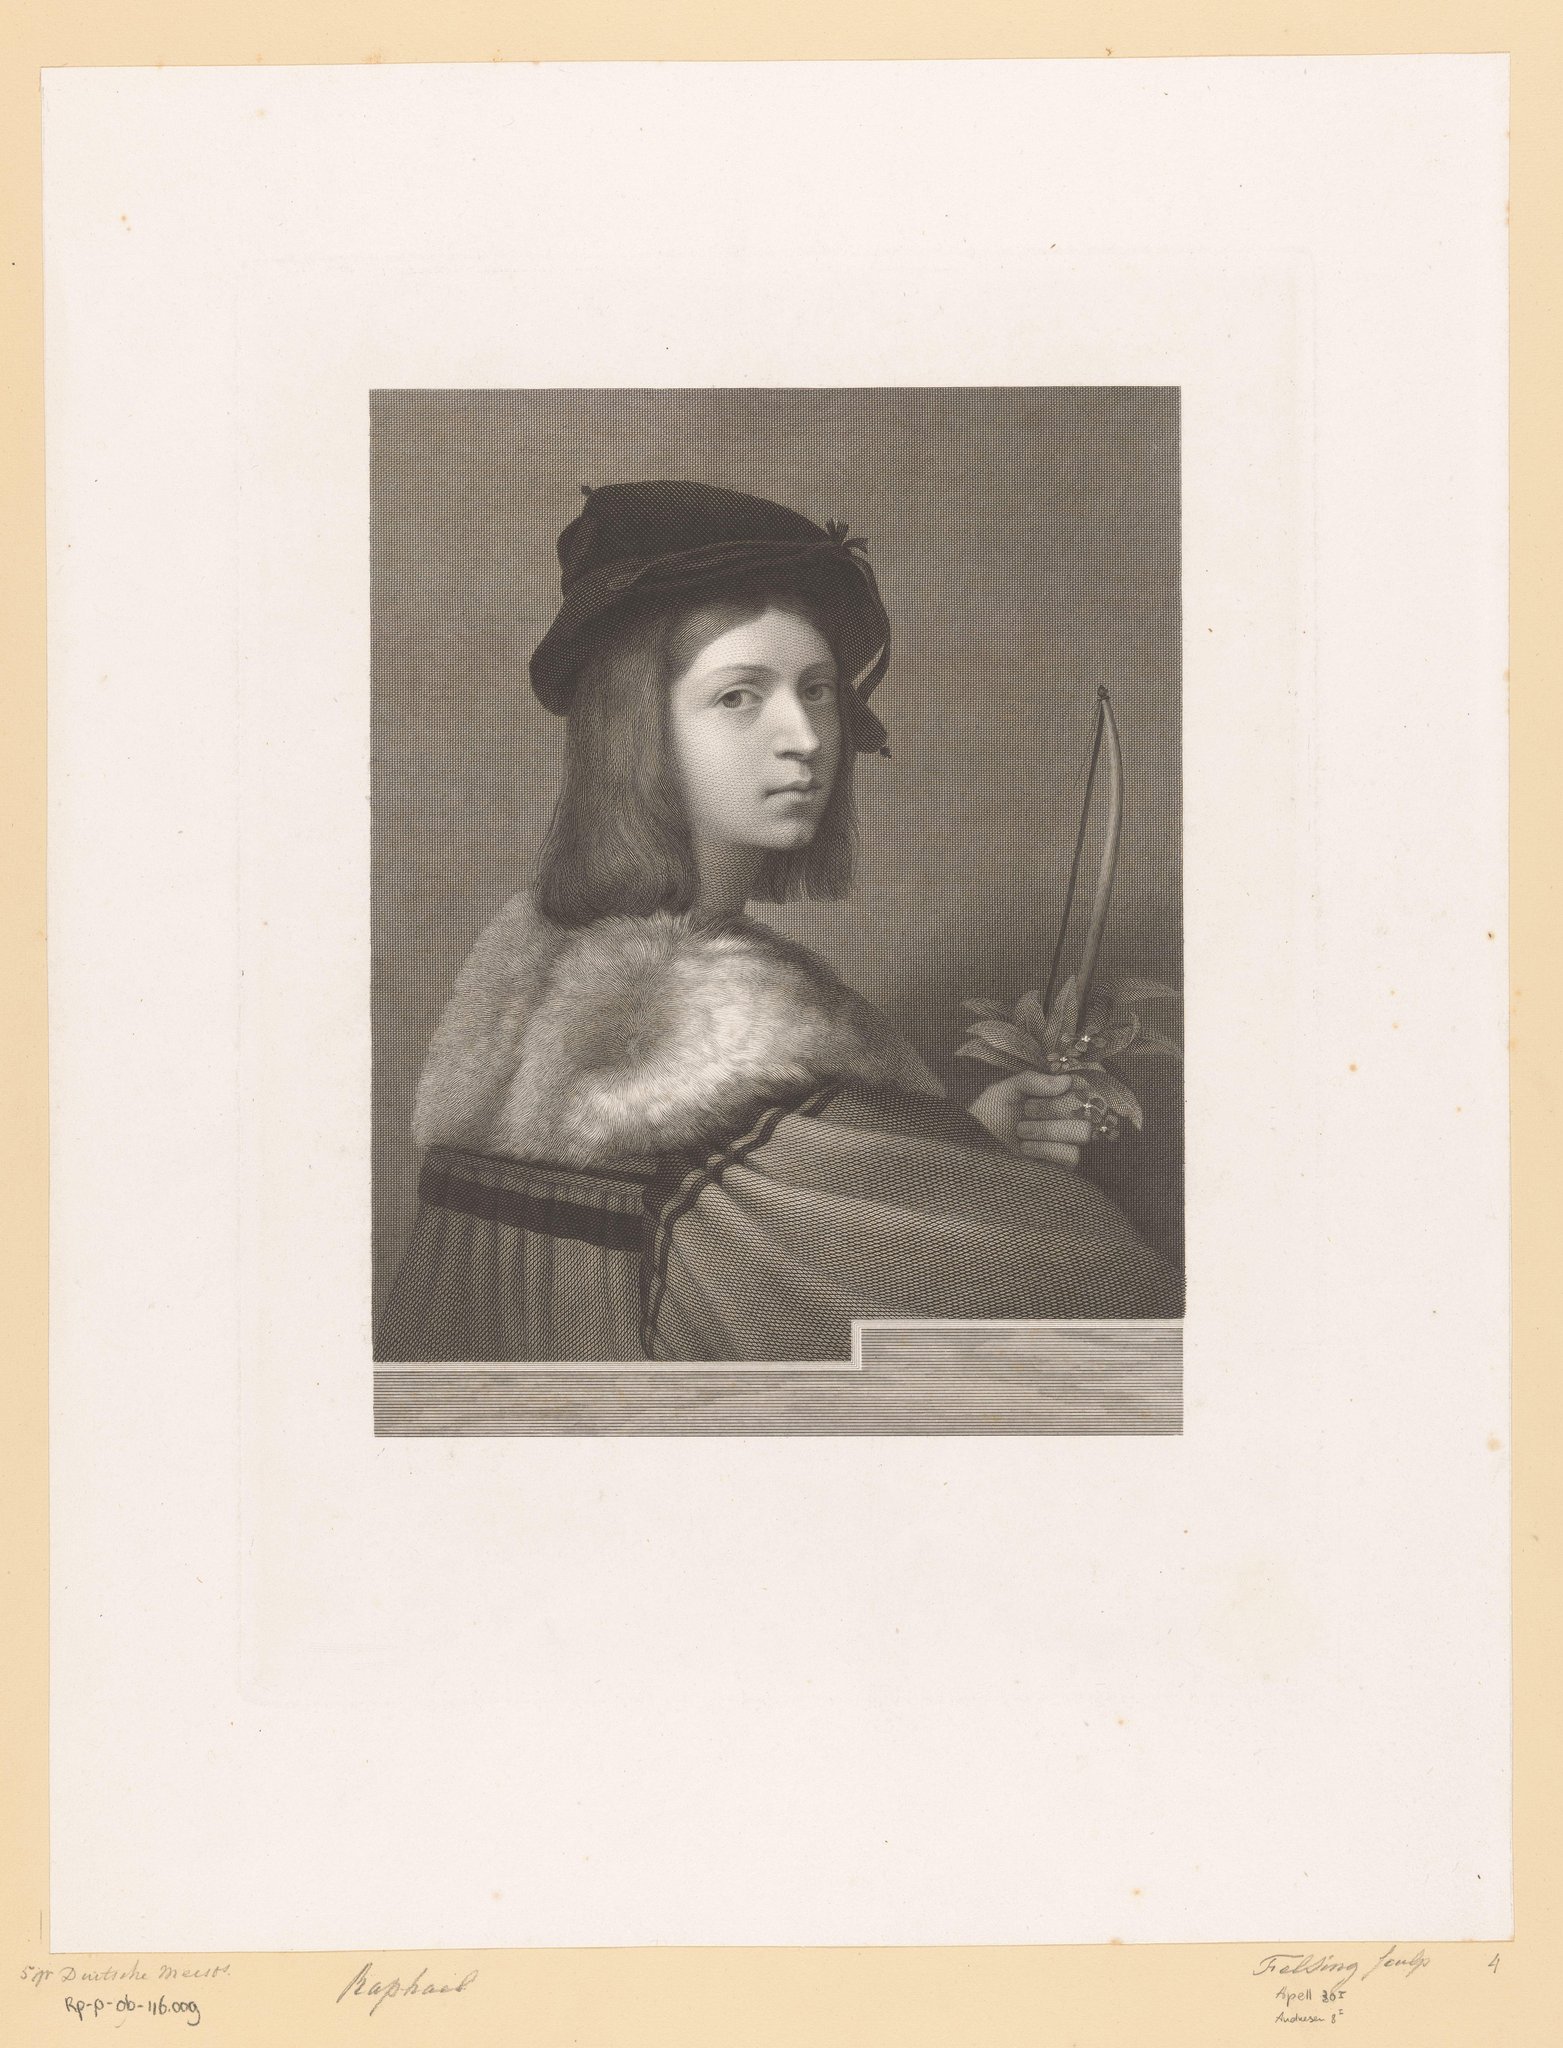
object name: print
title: Il Suonatore di violino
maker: jacob felsing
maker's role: print maker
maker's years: 1802-1883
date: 1834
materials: paper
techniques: engraving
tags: violin, fiddle, youth, adolescent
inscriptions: collector's mark: Lugt 12